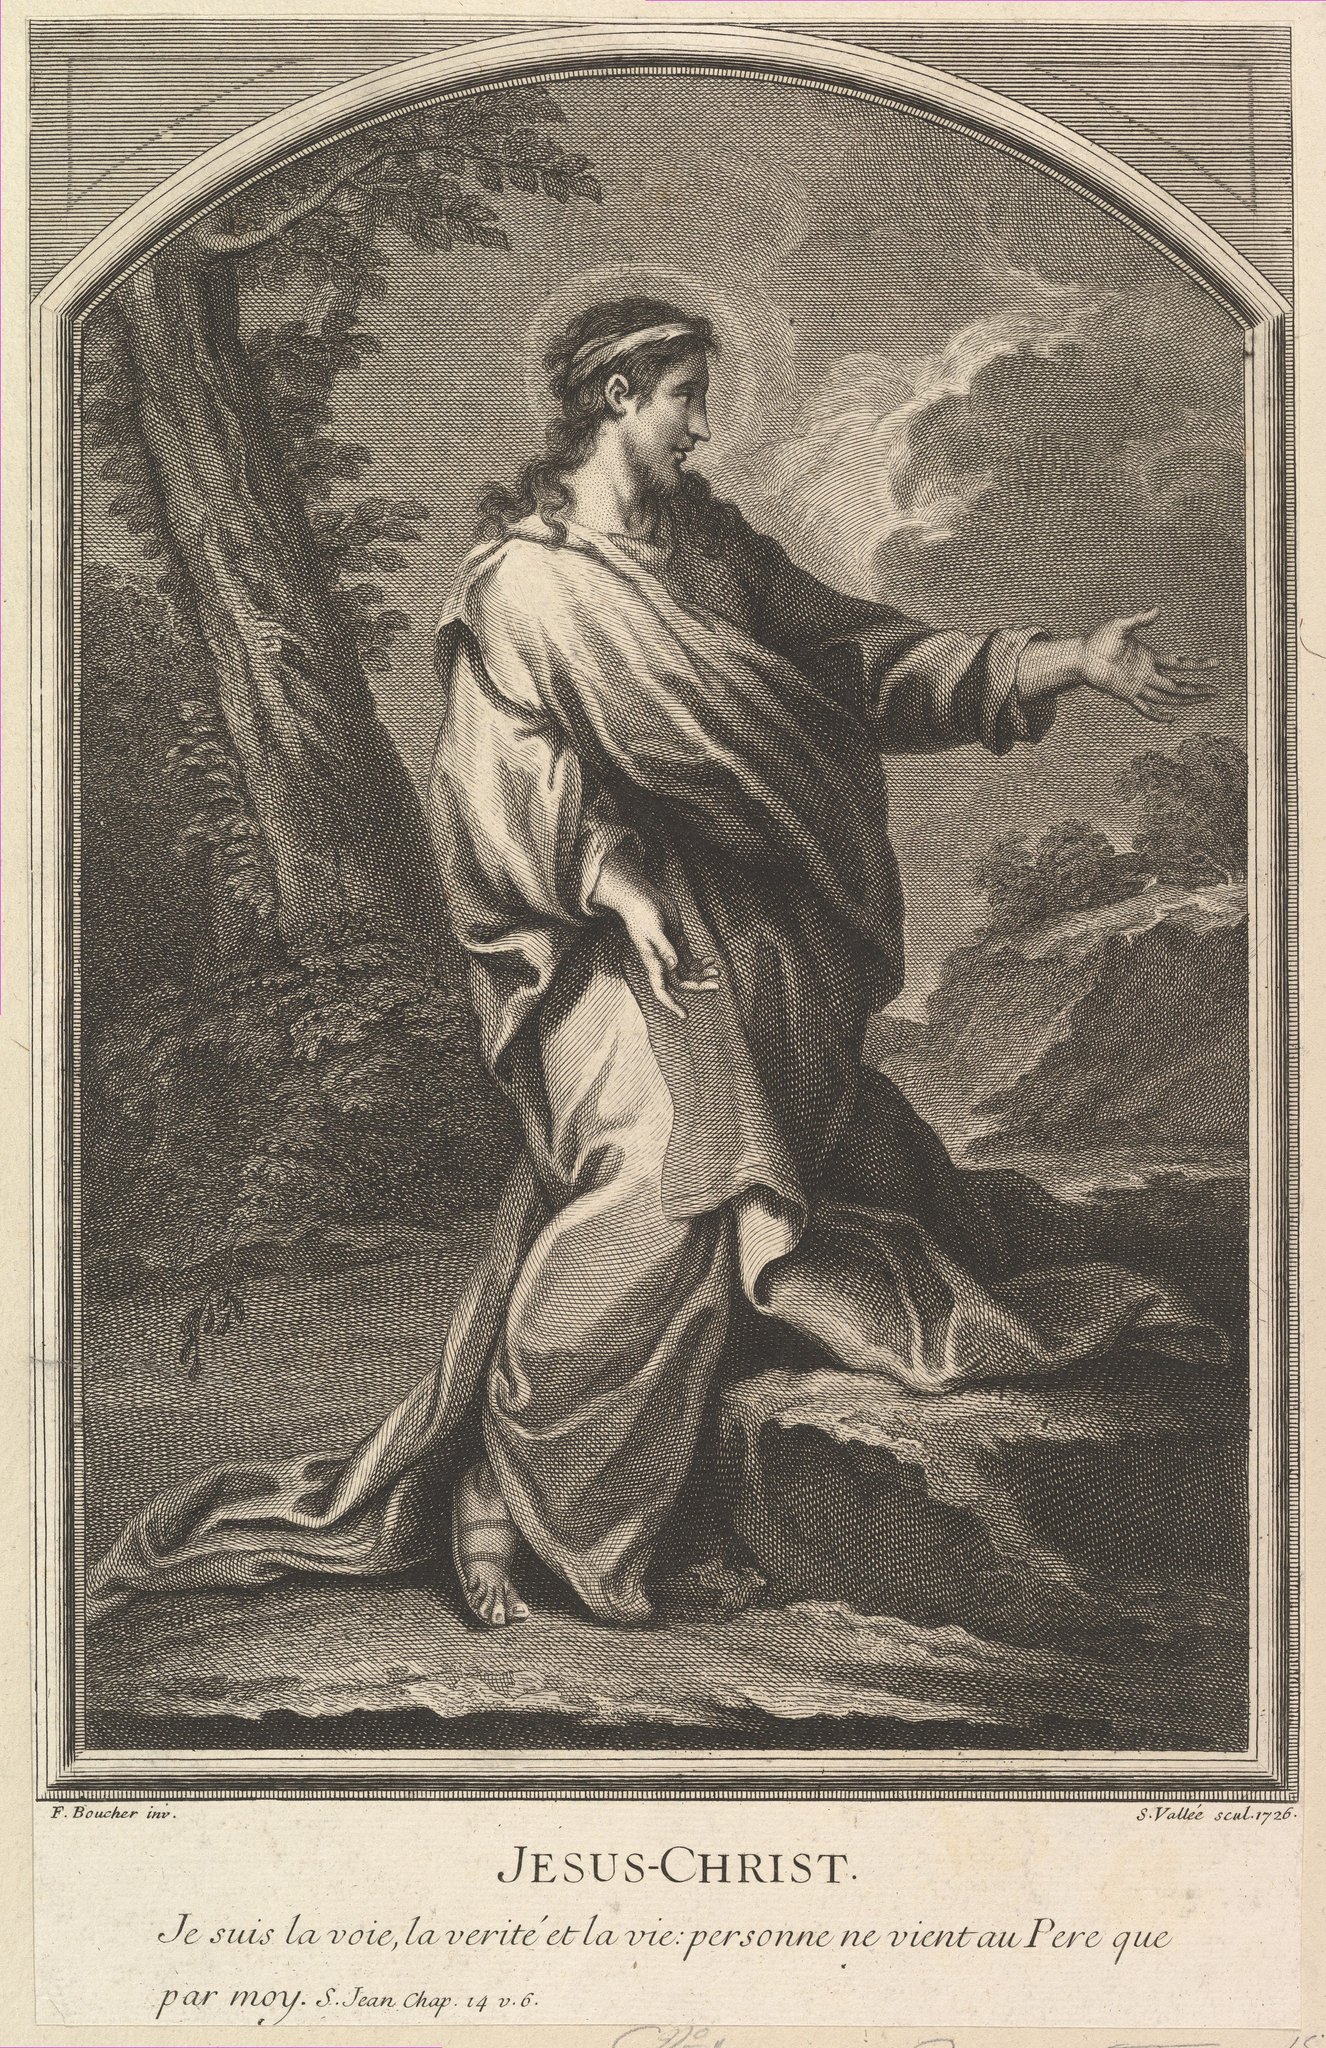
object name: print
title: Jesus Christ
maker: simon de la vallée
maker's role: artist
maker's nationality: french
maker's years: 1700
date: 1726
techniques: engraving, etching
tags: trees,jesus